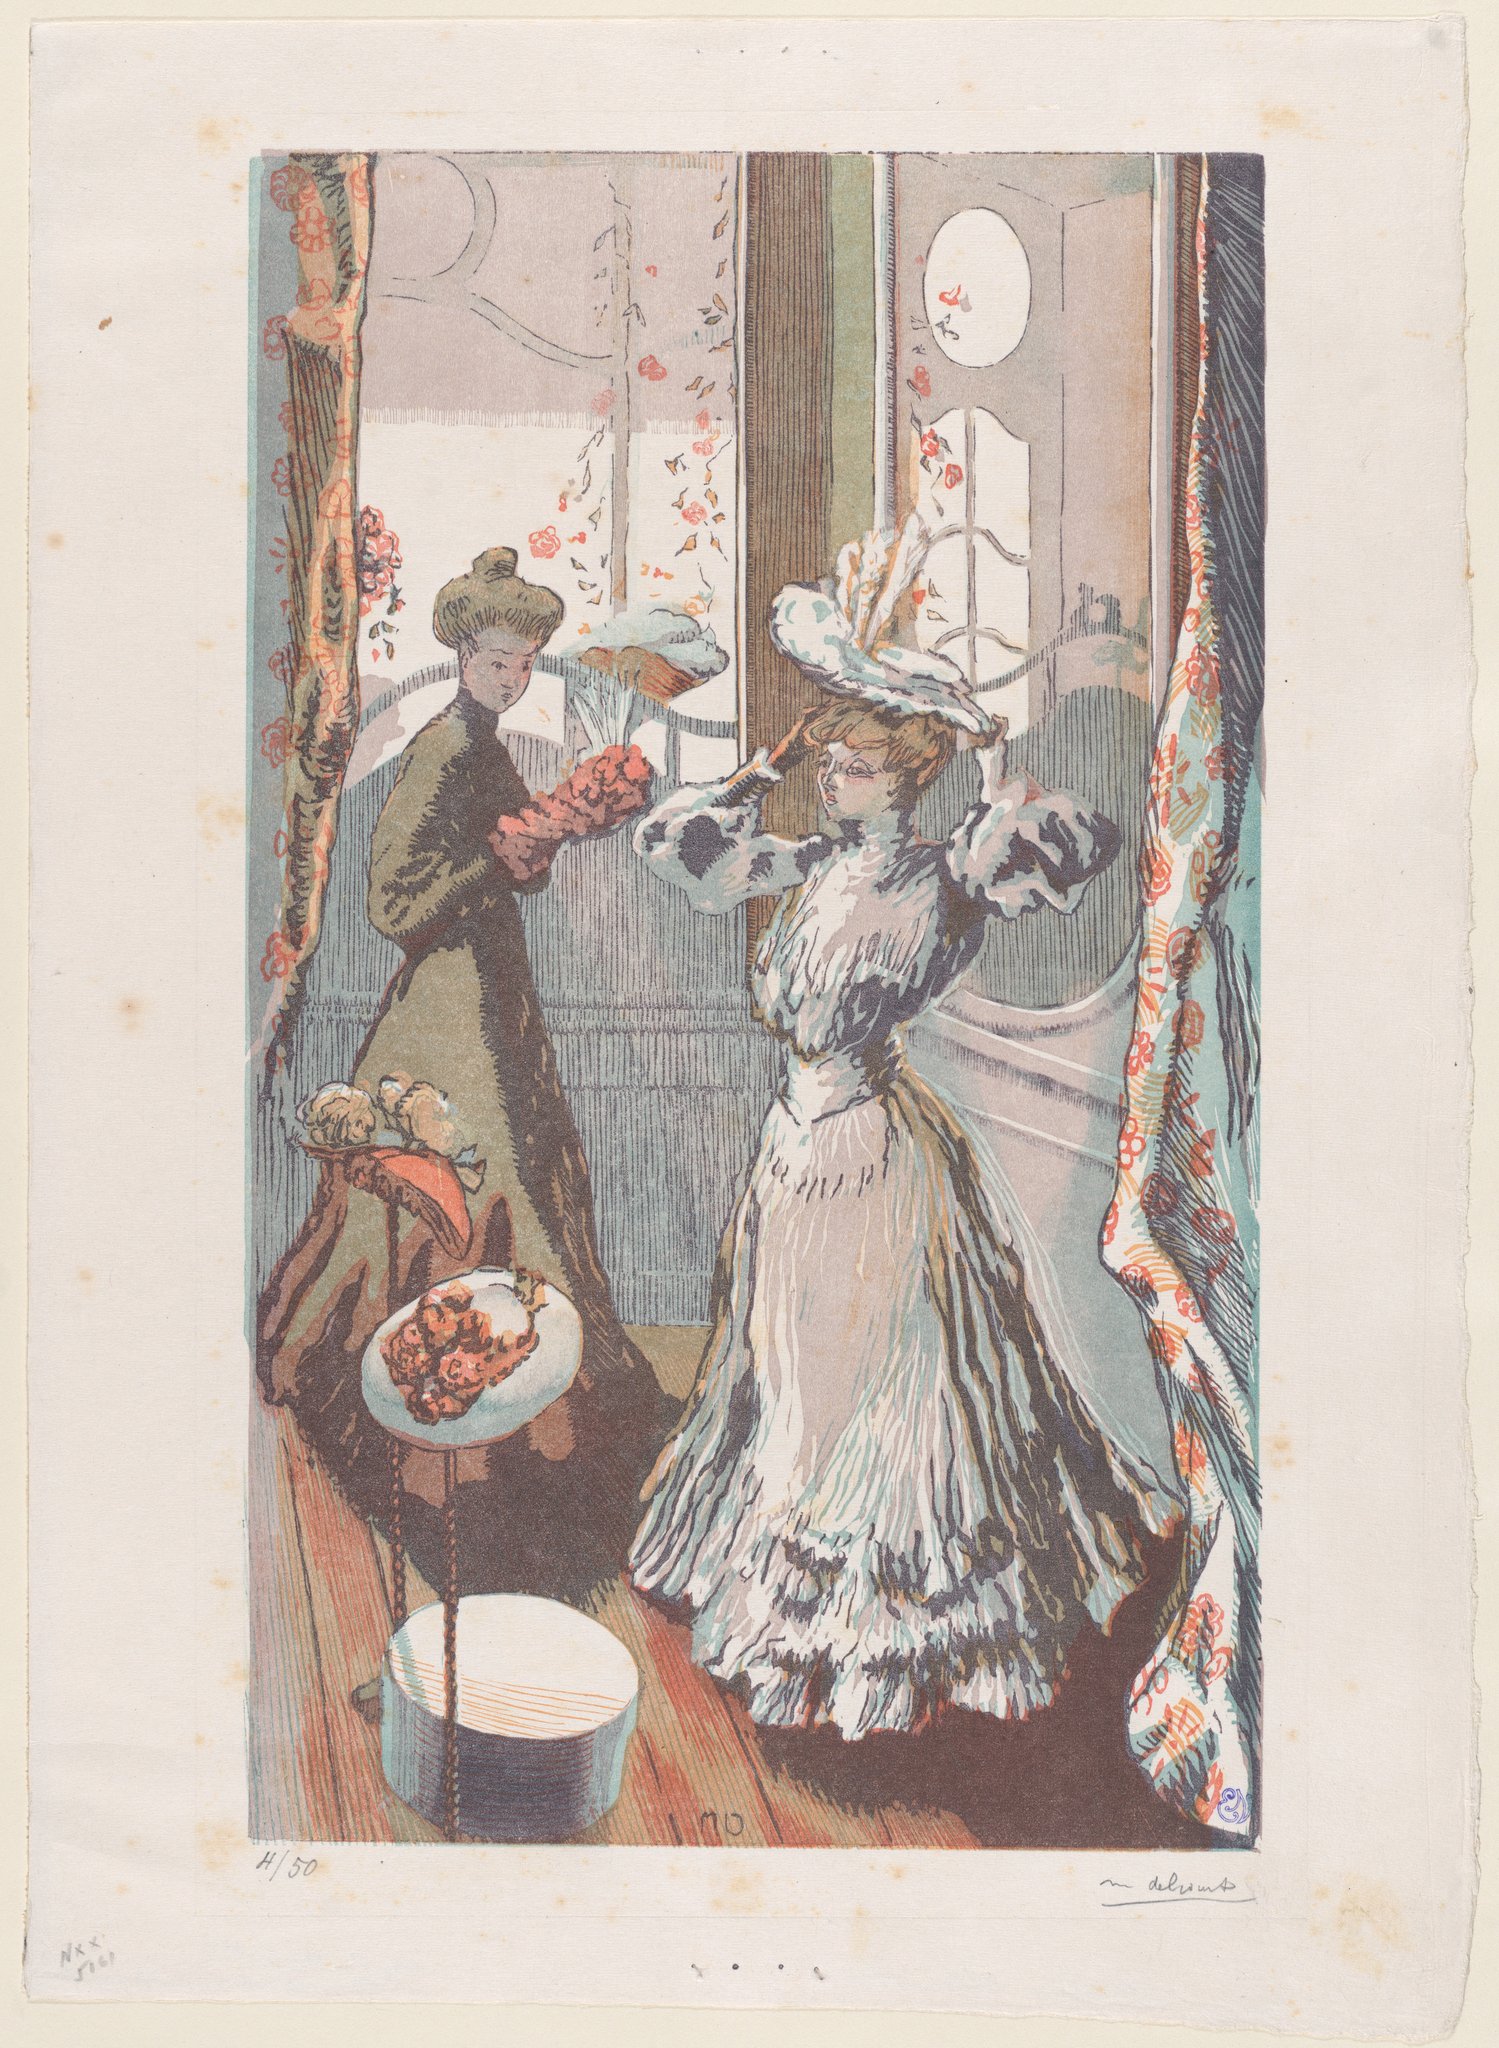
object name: print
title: Chez la Modiste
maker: maurice delcourt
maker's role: artist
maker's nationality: french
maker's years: 1877-1916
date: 1910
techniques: woodcut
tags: hats,women